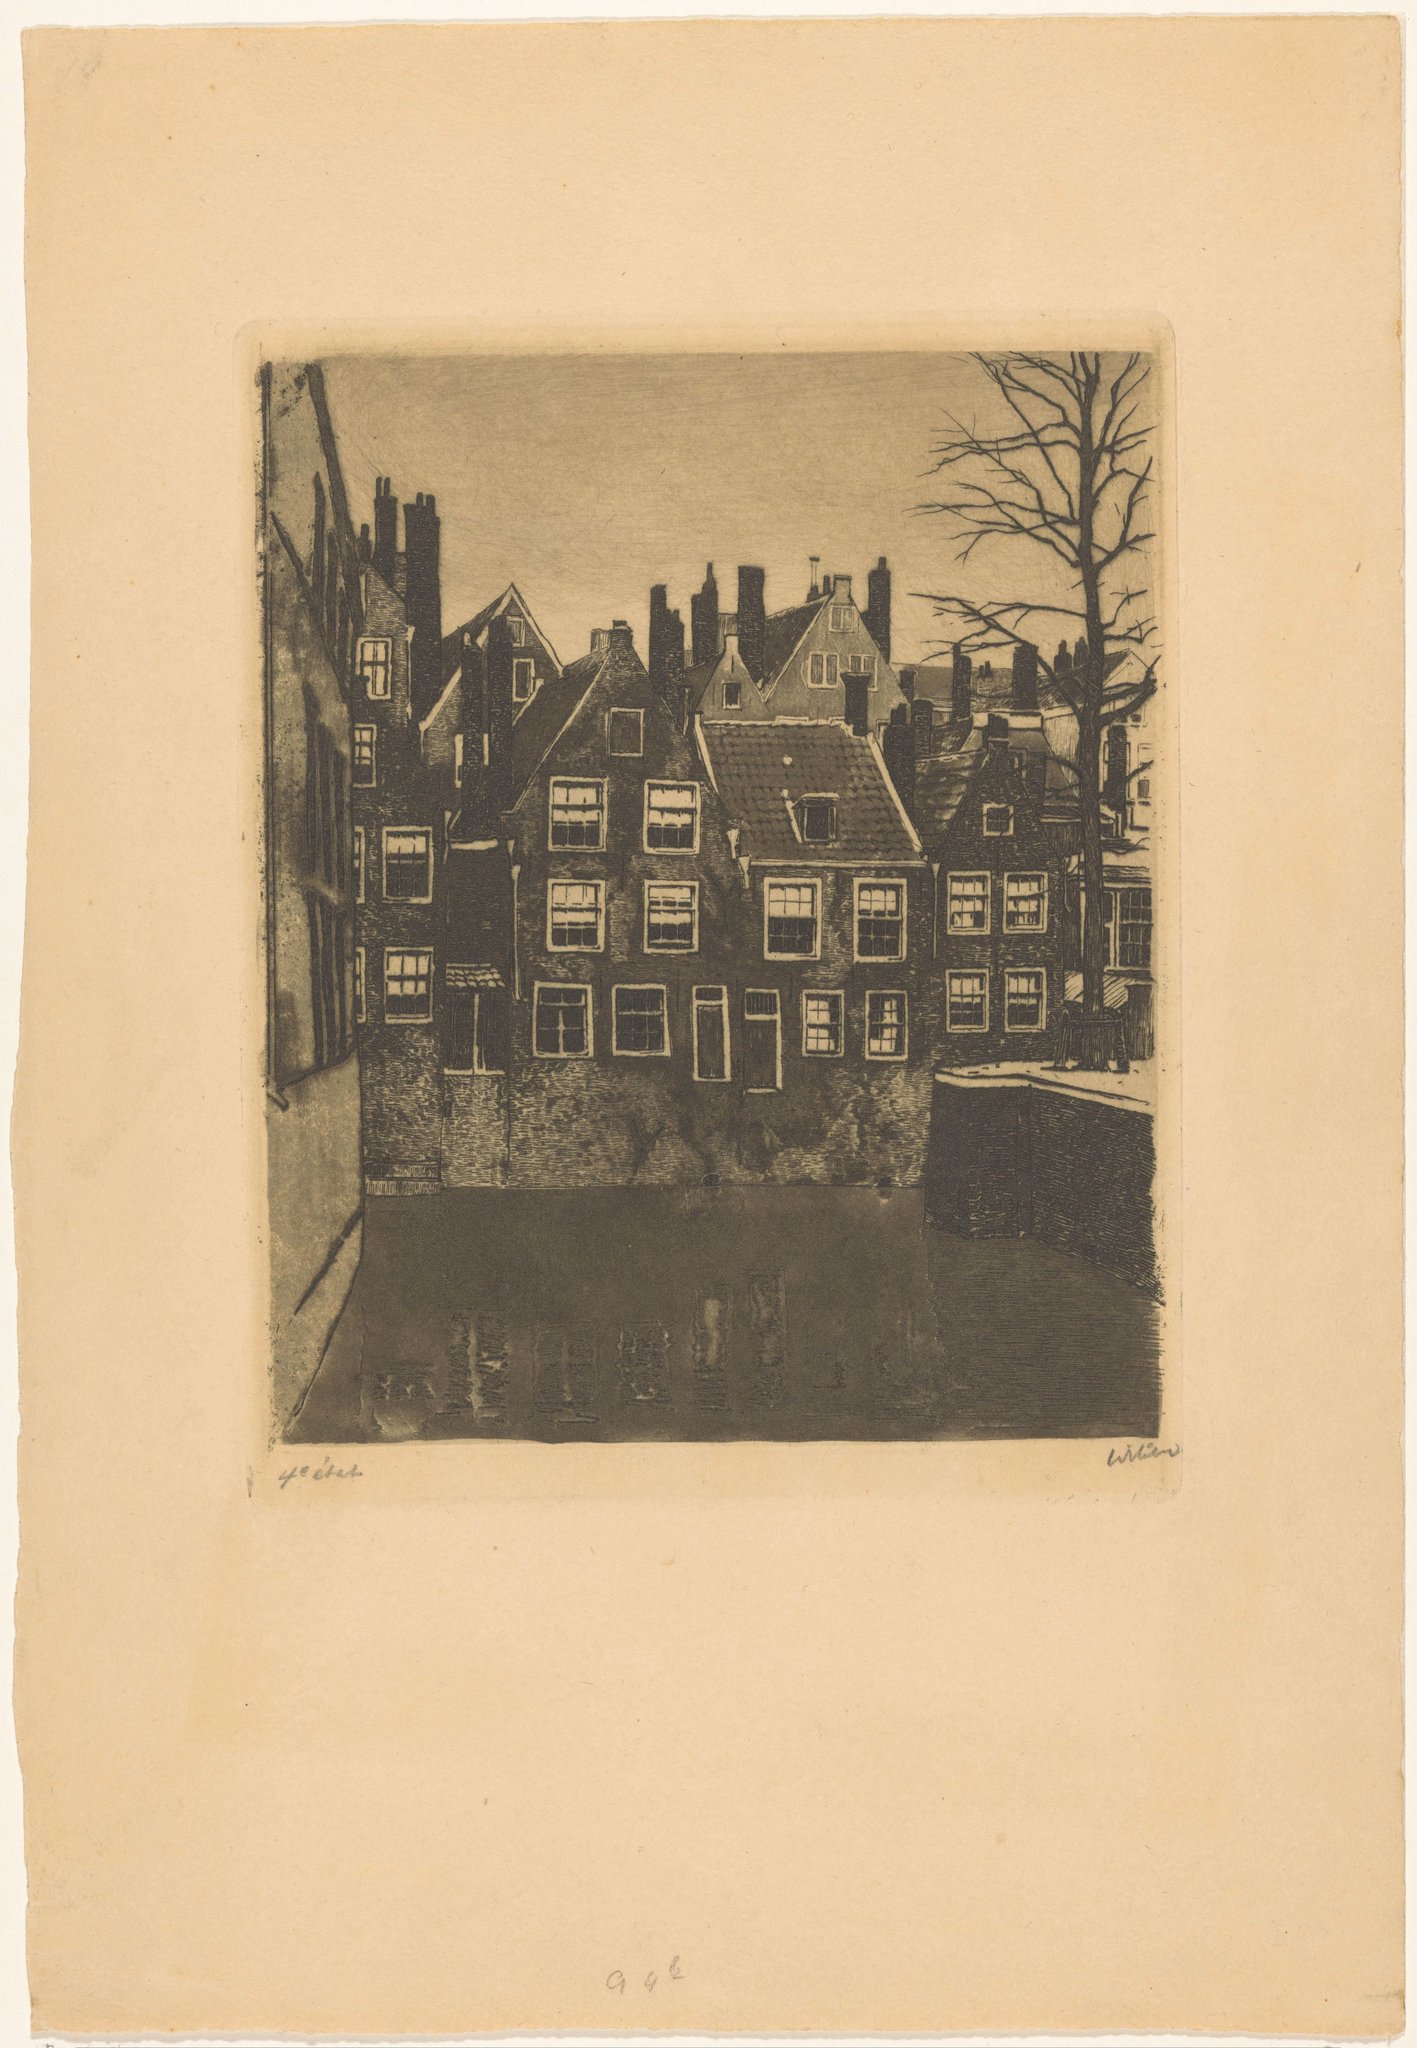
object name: print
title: Groenendaal in Rotterdam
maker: willem witsen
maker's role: draughtsman, painter, print maker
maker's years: 1860-1923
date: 1897-1898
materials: paper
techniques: aquatint, drypoint, etching, intaglio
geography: amsterdam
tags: urban housing, trees, canals, waters (in city)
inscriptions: inscription: ‘4e état’, signature: ‘Witsen’